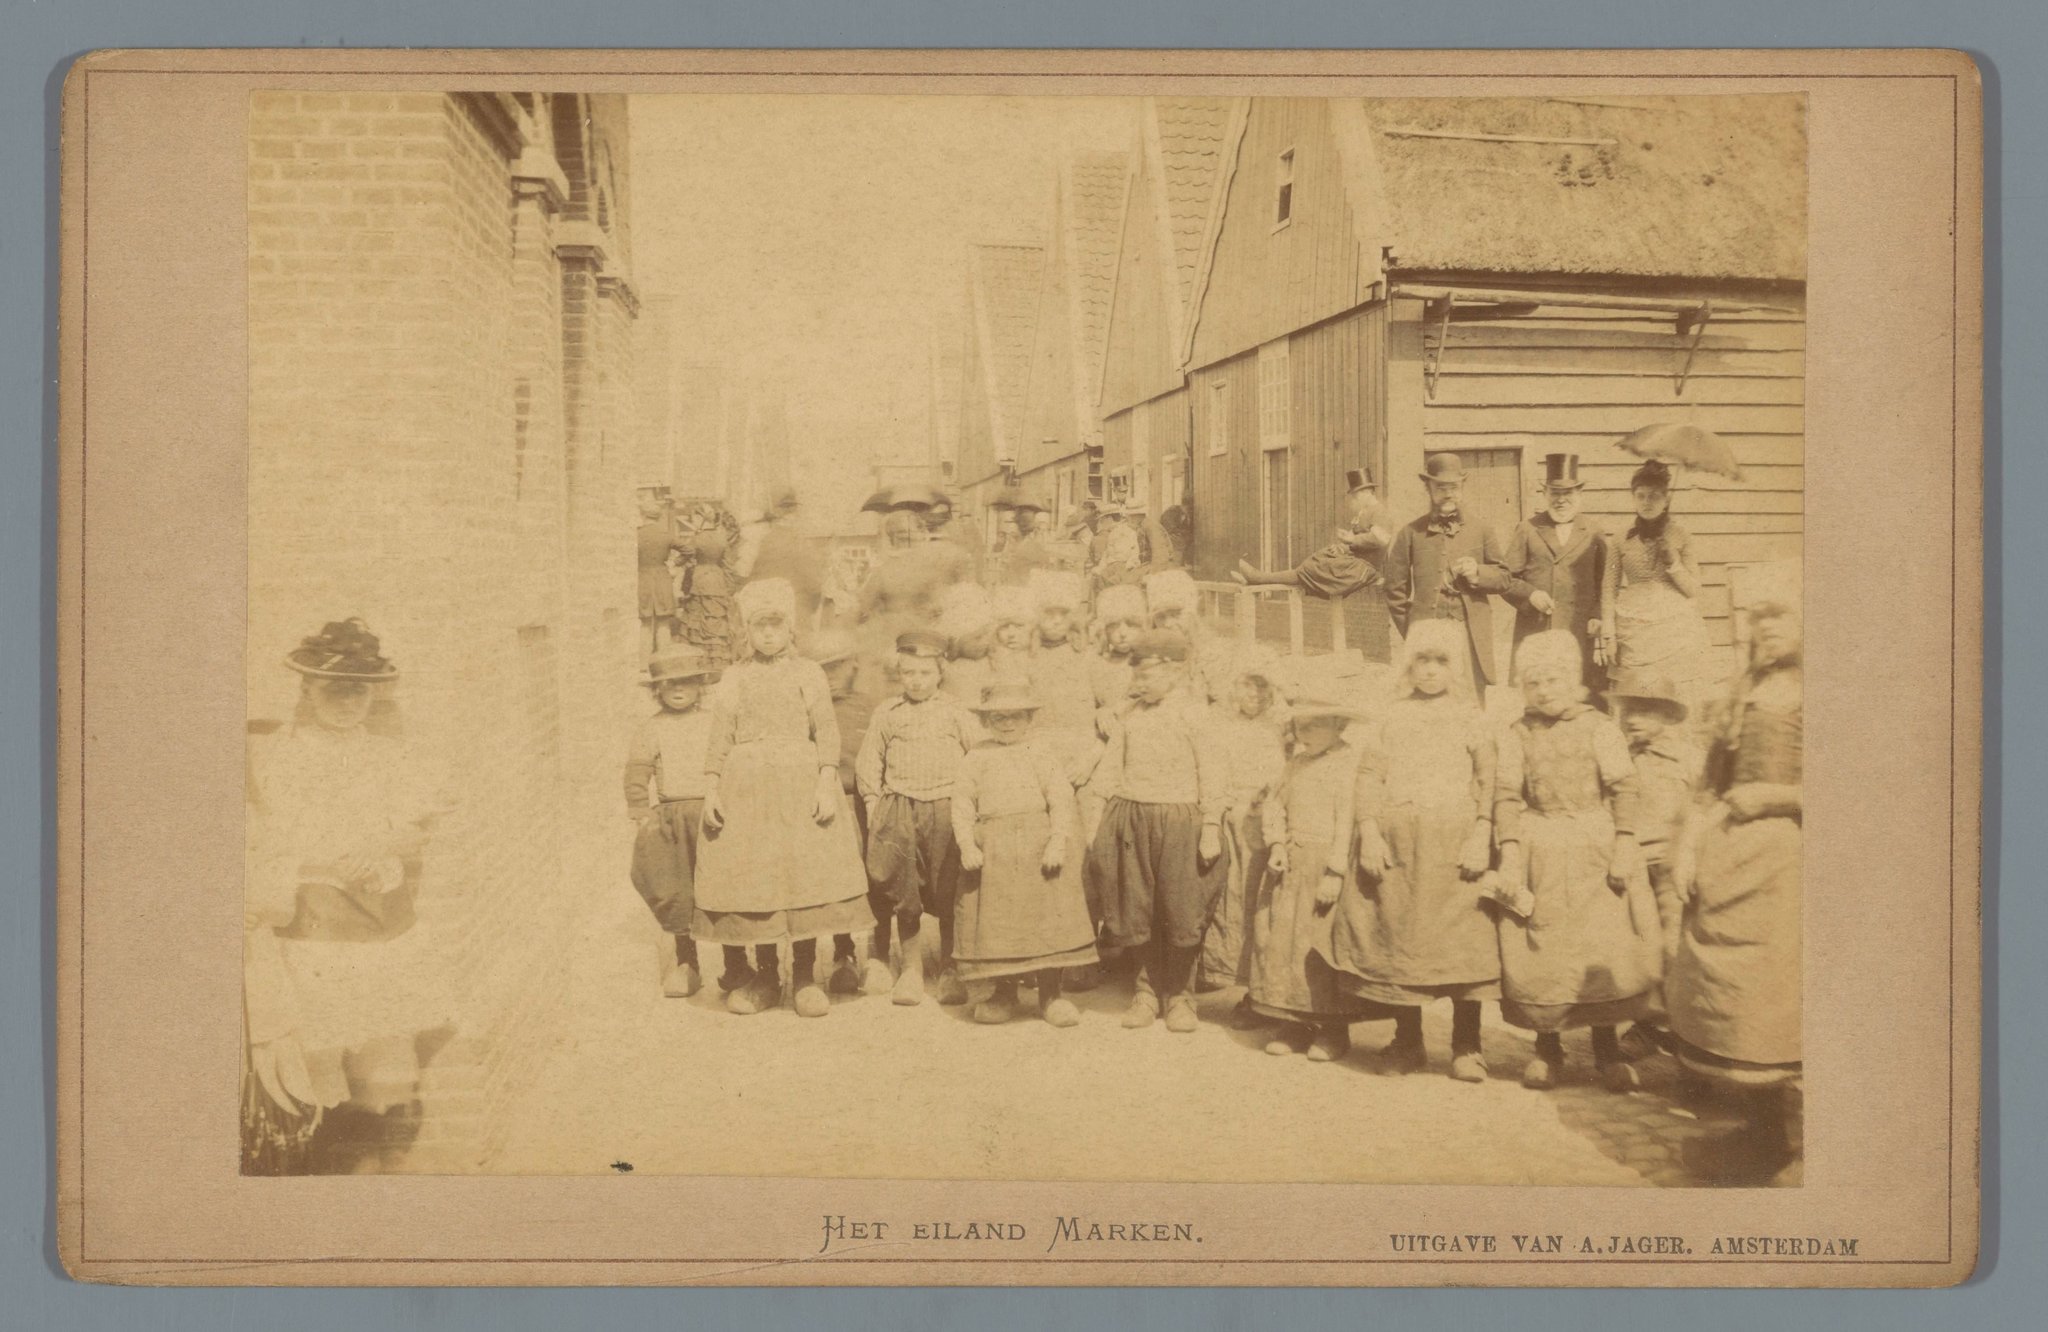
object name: photograph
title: Het eiland Marken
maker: andries jager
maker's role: publisher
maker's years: 1825-1905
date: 1850-1890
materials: cardboard, photographic support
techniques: albumen print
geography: marken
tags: folk costume, regional costume, anonymous historical persons portrayed in a group, in a group-portrait